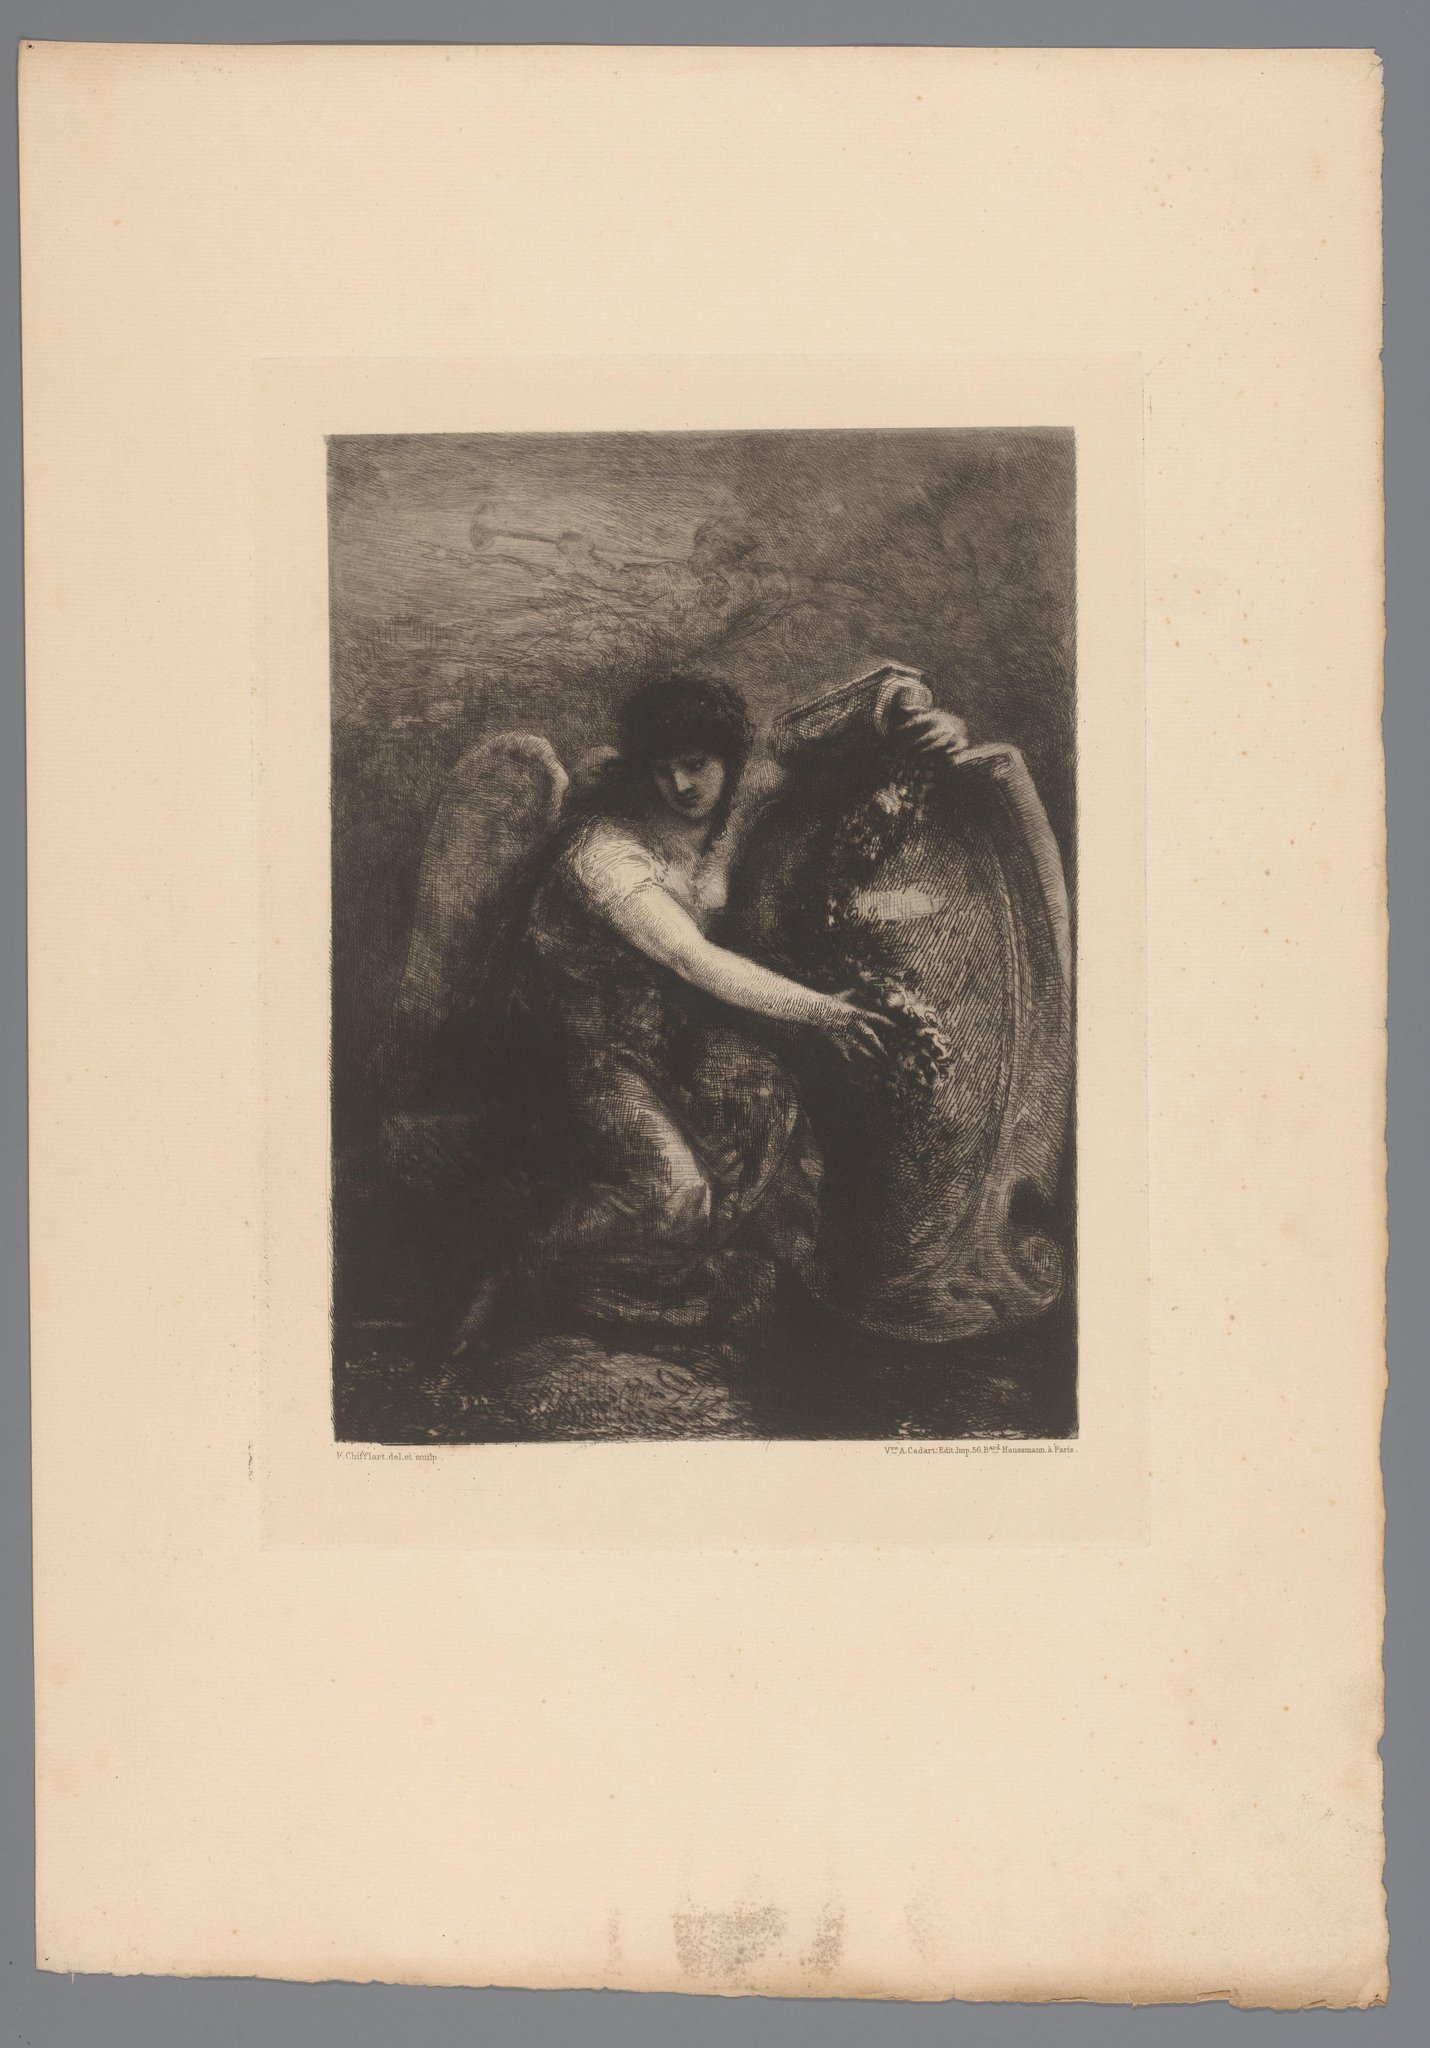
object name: print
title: L'eau-forte en 1881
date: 1881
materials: paper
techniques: drypoint, etching, intaglio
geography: paris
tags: ornament ~ cartouche, angels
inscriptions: watermark, collector's mark: Lugt 2760, collector's mark: Lugt 2228, collector's mark: ‘AFE v S’